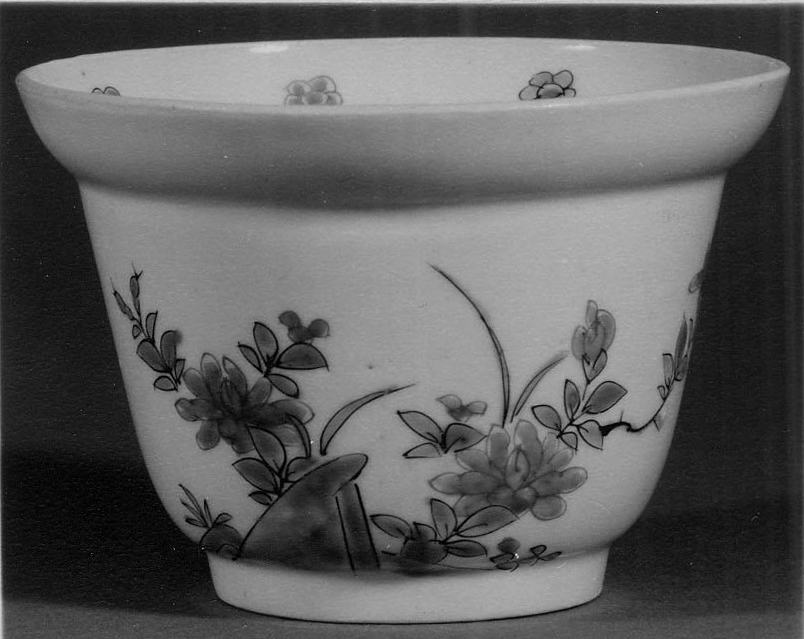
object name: cup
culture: japanese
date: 1601-1700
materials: enamel, porcelain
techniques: overglaze, painting, polychrome